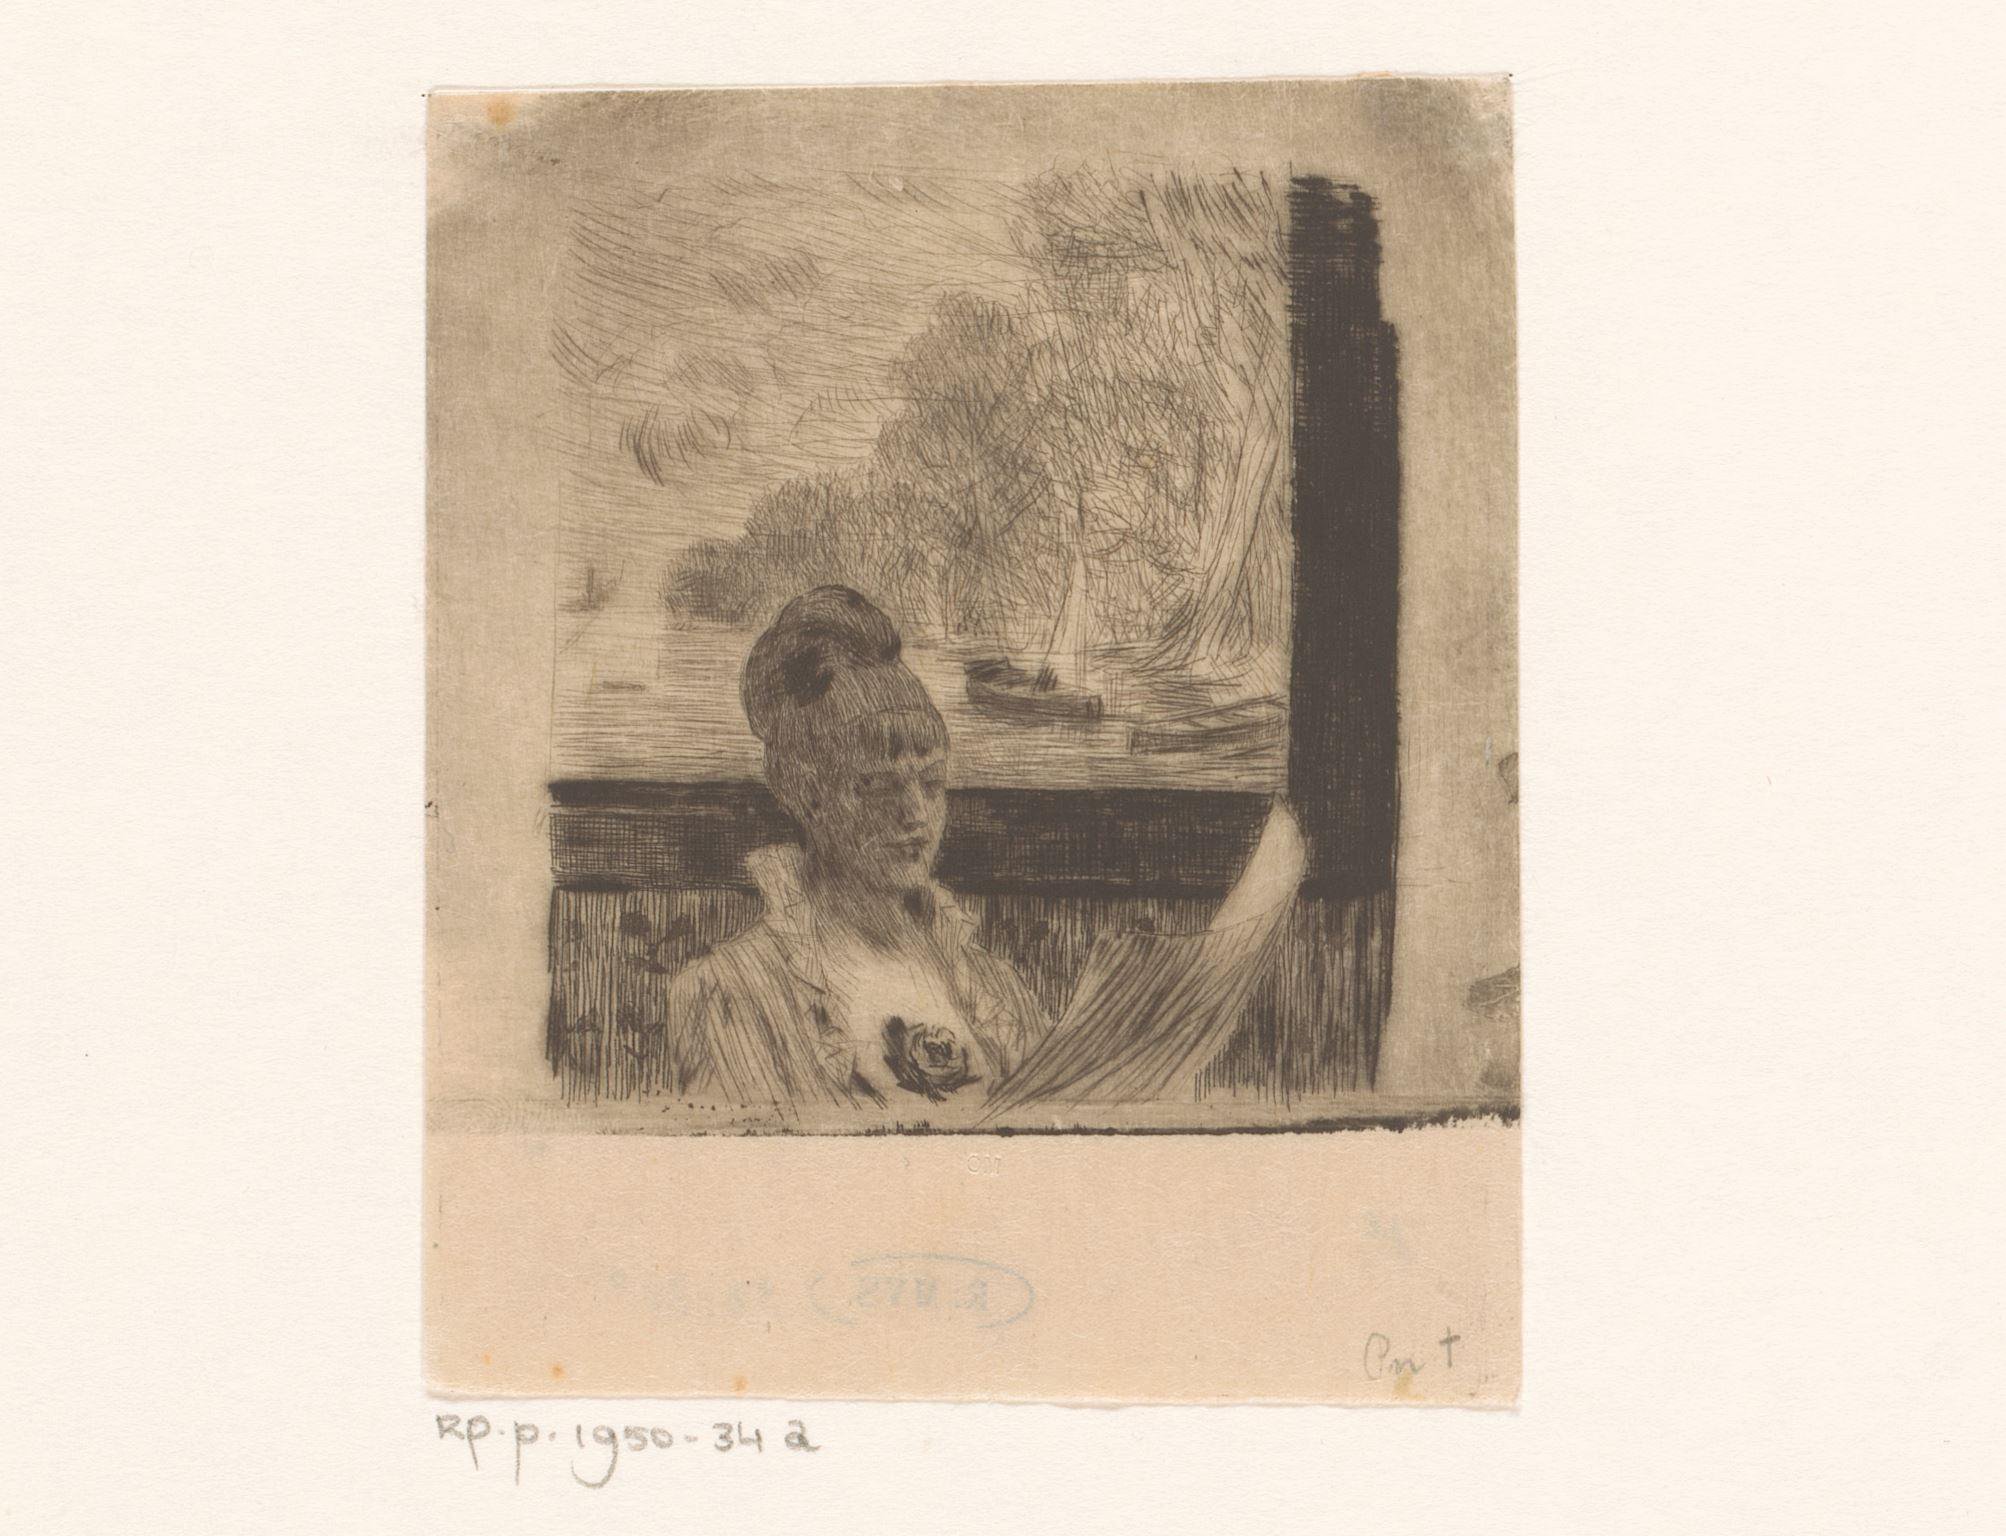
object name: print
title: Petite liseuse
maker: félicien rops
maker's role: draughtsman, print maker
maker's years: 1833-1898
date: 1876-1879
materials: paper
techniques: aquatint, drypoint, etching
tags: adult woman, reading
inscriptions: collector's mark: Lugt 601, collector's mark: Lugt 2228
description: Oorspronkelijk is deze afbeelding deel van een grotere prent, waarop nog vijf afbeeldingen te zien zijn.